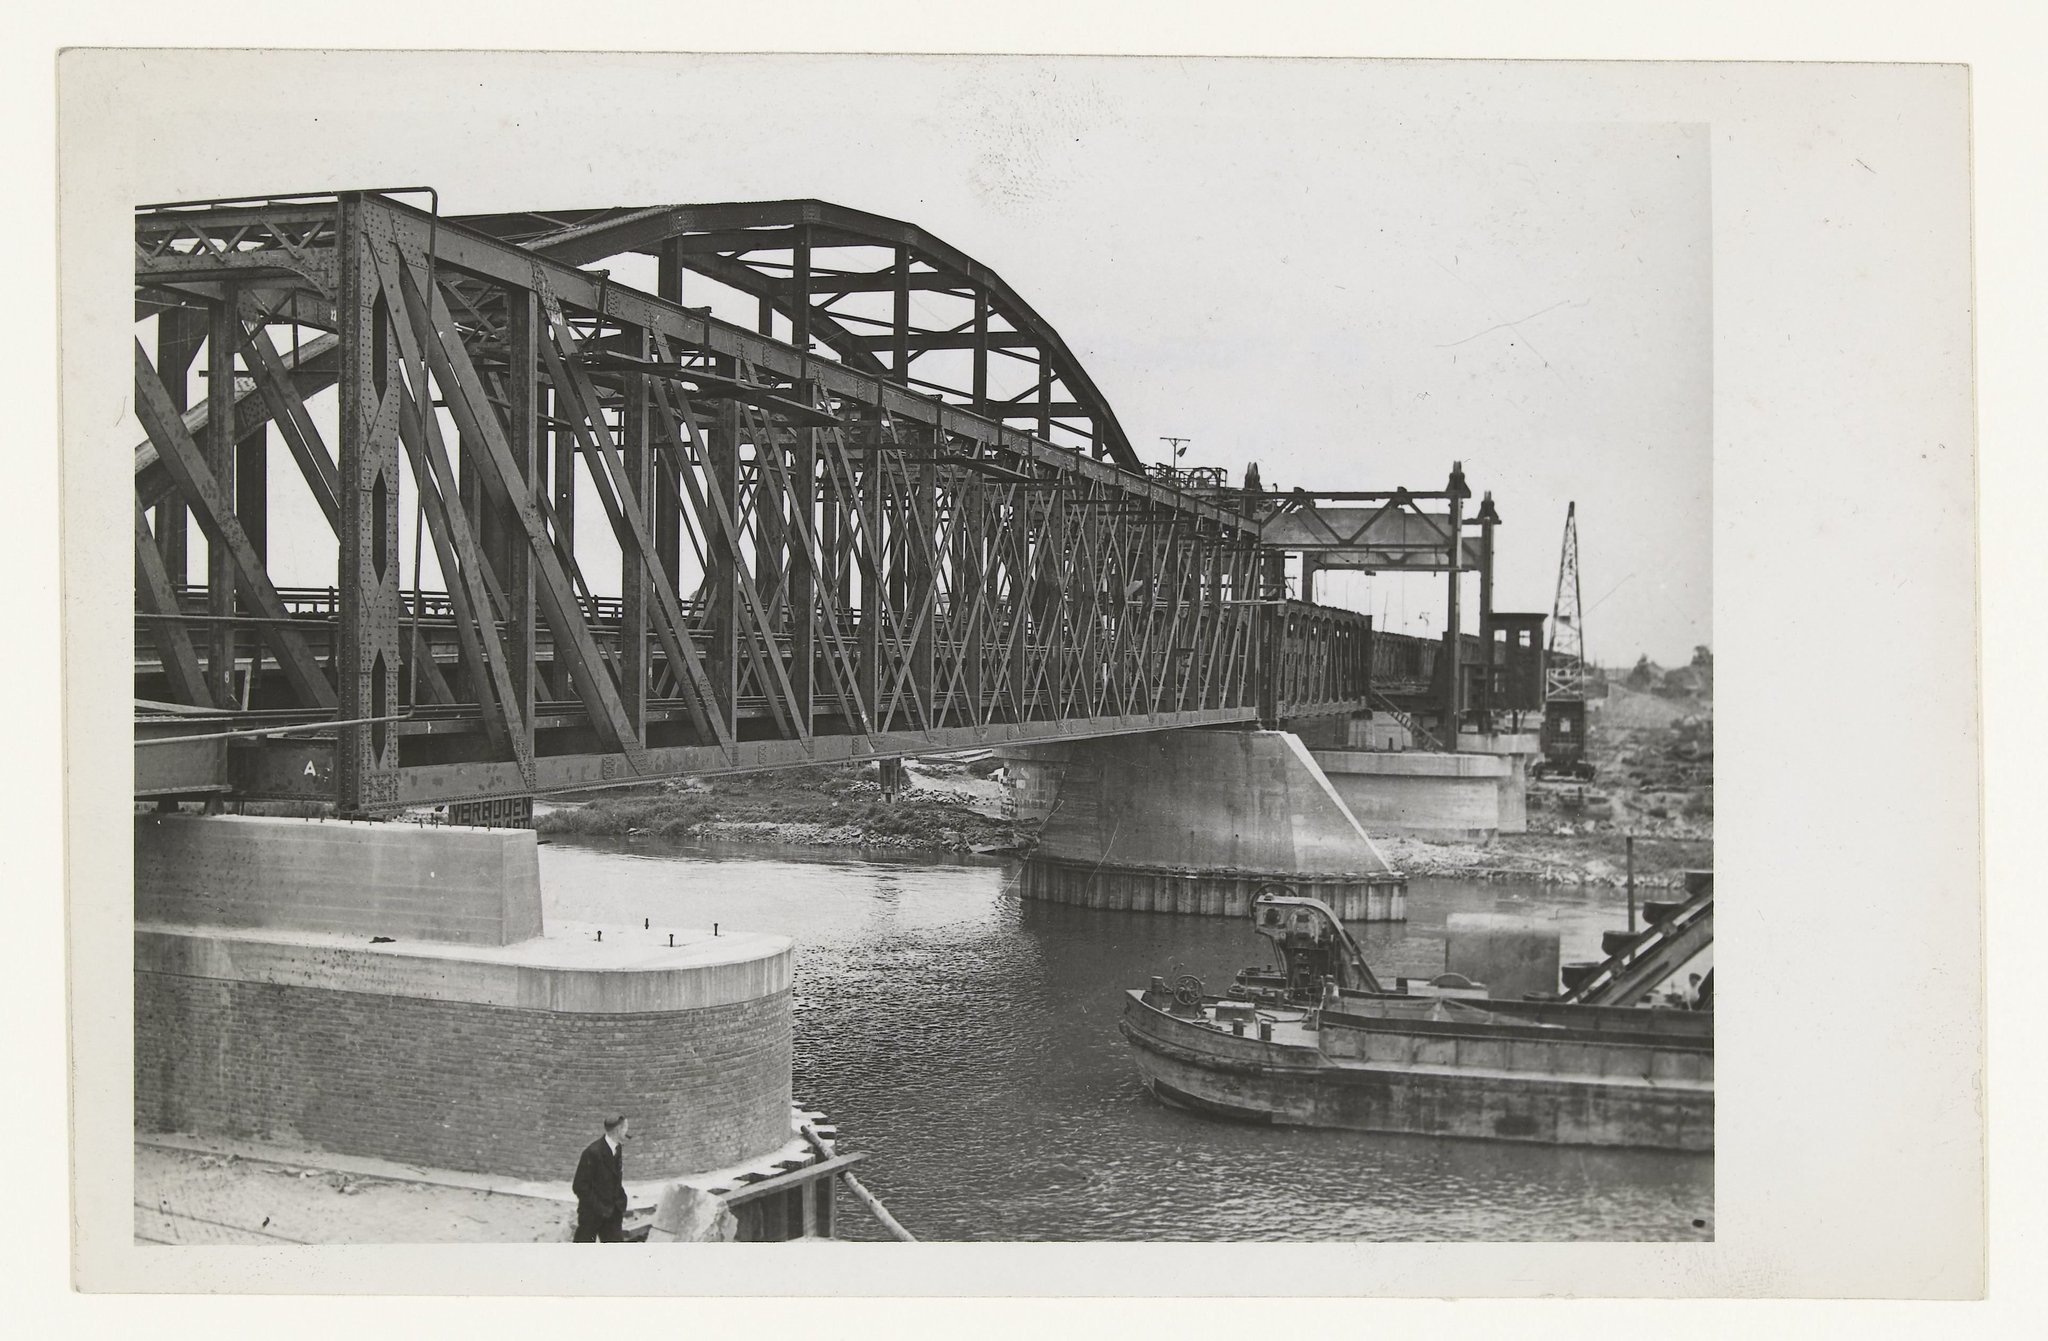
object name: documentary photograph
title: Herstelde spoorbrug Zutphen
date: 1946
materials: photographic support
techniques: photography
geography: zutphen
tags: zutphen (stad), tweede wereldoorlog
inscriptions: number: ‘18824’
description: Tijdens WOII waren maar liefst 180 spoorbruggen vernield; van de grote spoorbruggen bleven slechts drie intact en dit resulteerde in zeer slechte verbindingen, weg-en spoorverkeer kwam moeizaam op gang.